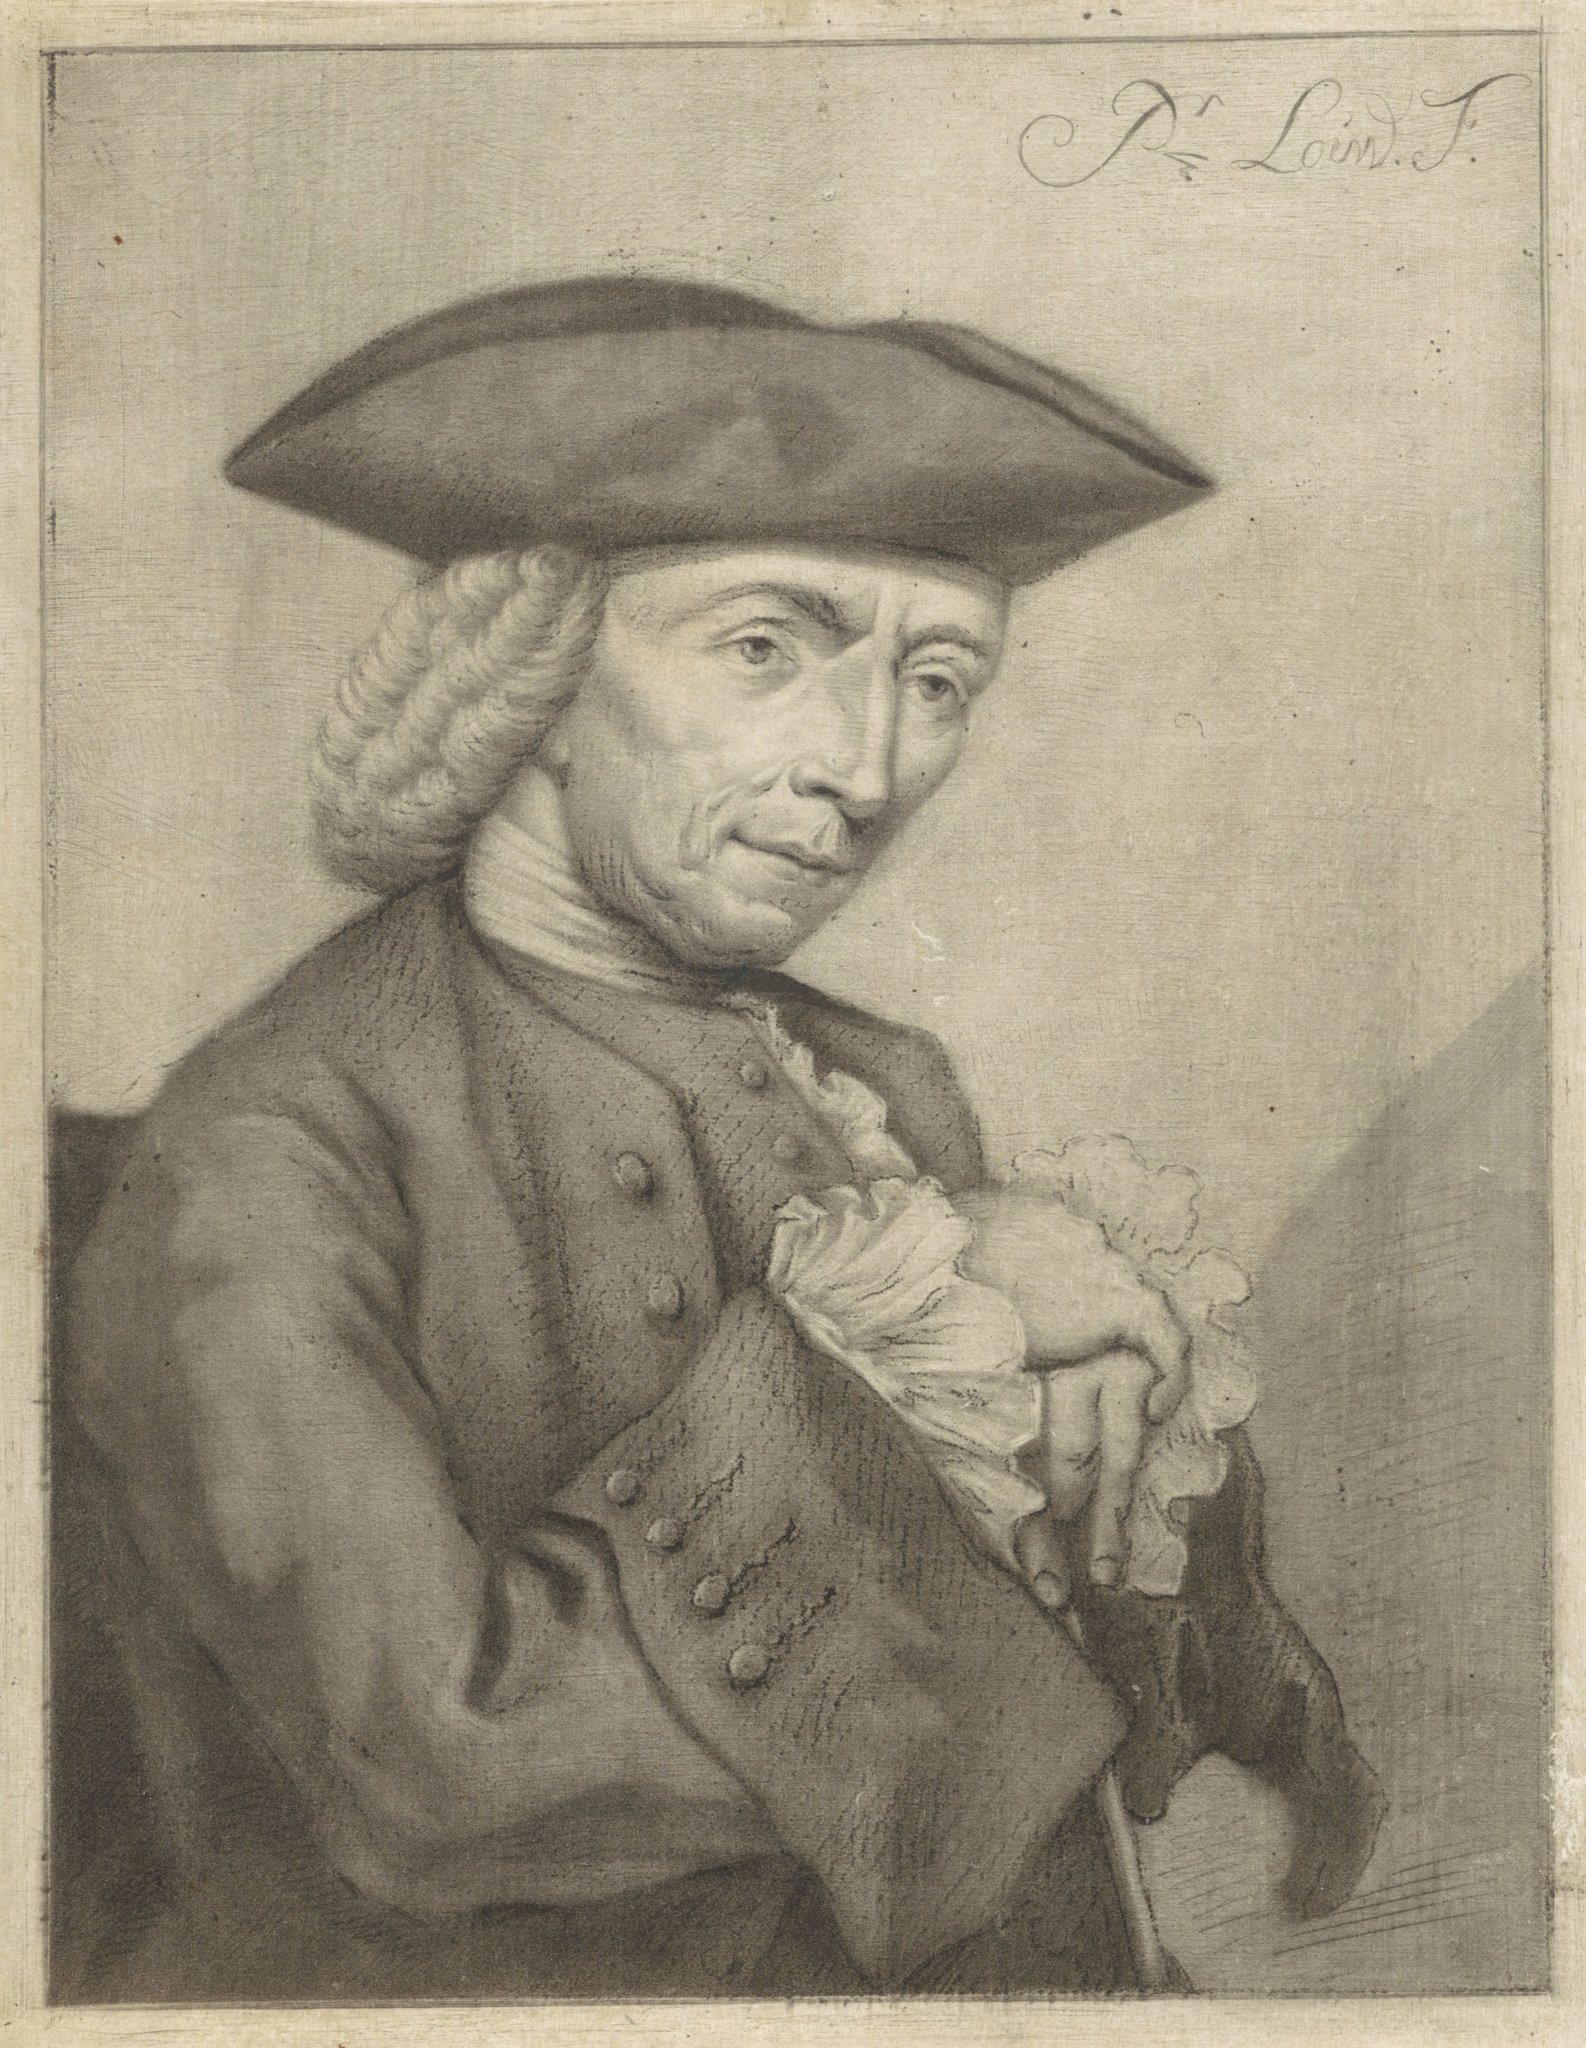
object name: print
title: Portret van Hendrik Spilman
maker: pieter louw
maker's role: draughtsman, print maker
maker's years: 1725-1800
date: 1743-1800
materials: paper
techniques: mezzotint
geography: amsterdam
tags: amsterdam, haarlem, painter, print maker, draughtsman, hendrik spilman, head-gear: hat (+ men's clothes), portrait, self-portrait of artist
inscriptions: collector's mark: Lugt 2228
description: De prentmaker, tekenaar en schilder Hendrik Spilman. Hij laat zijn over elkaar gevouwen handen op zijn wandelstok rusten.